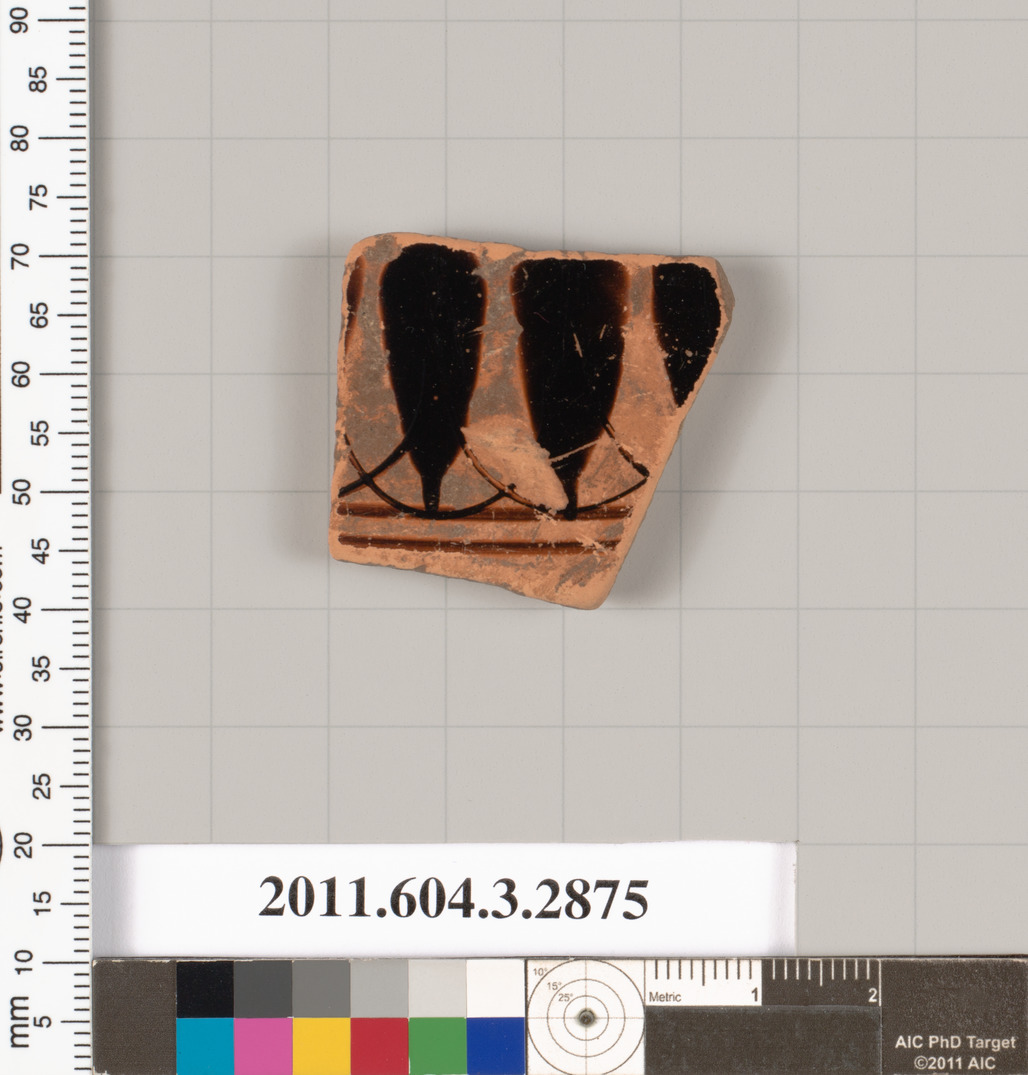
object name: neck amphora fragment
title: Terracotta fragment of a neck-amphora (jar)?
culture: greek, attic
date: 550-501 BCE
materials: terracotta